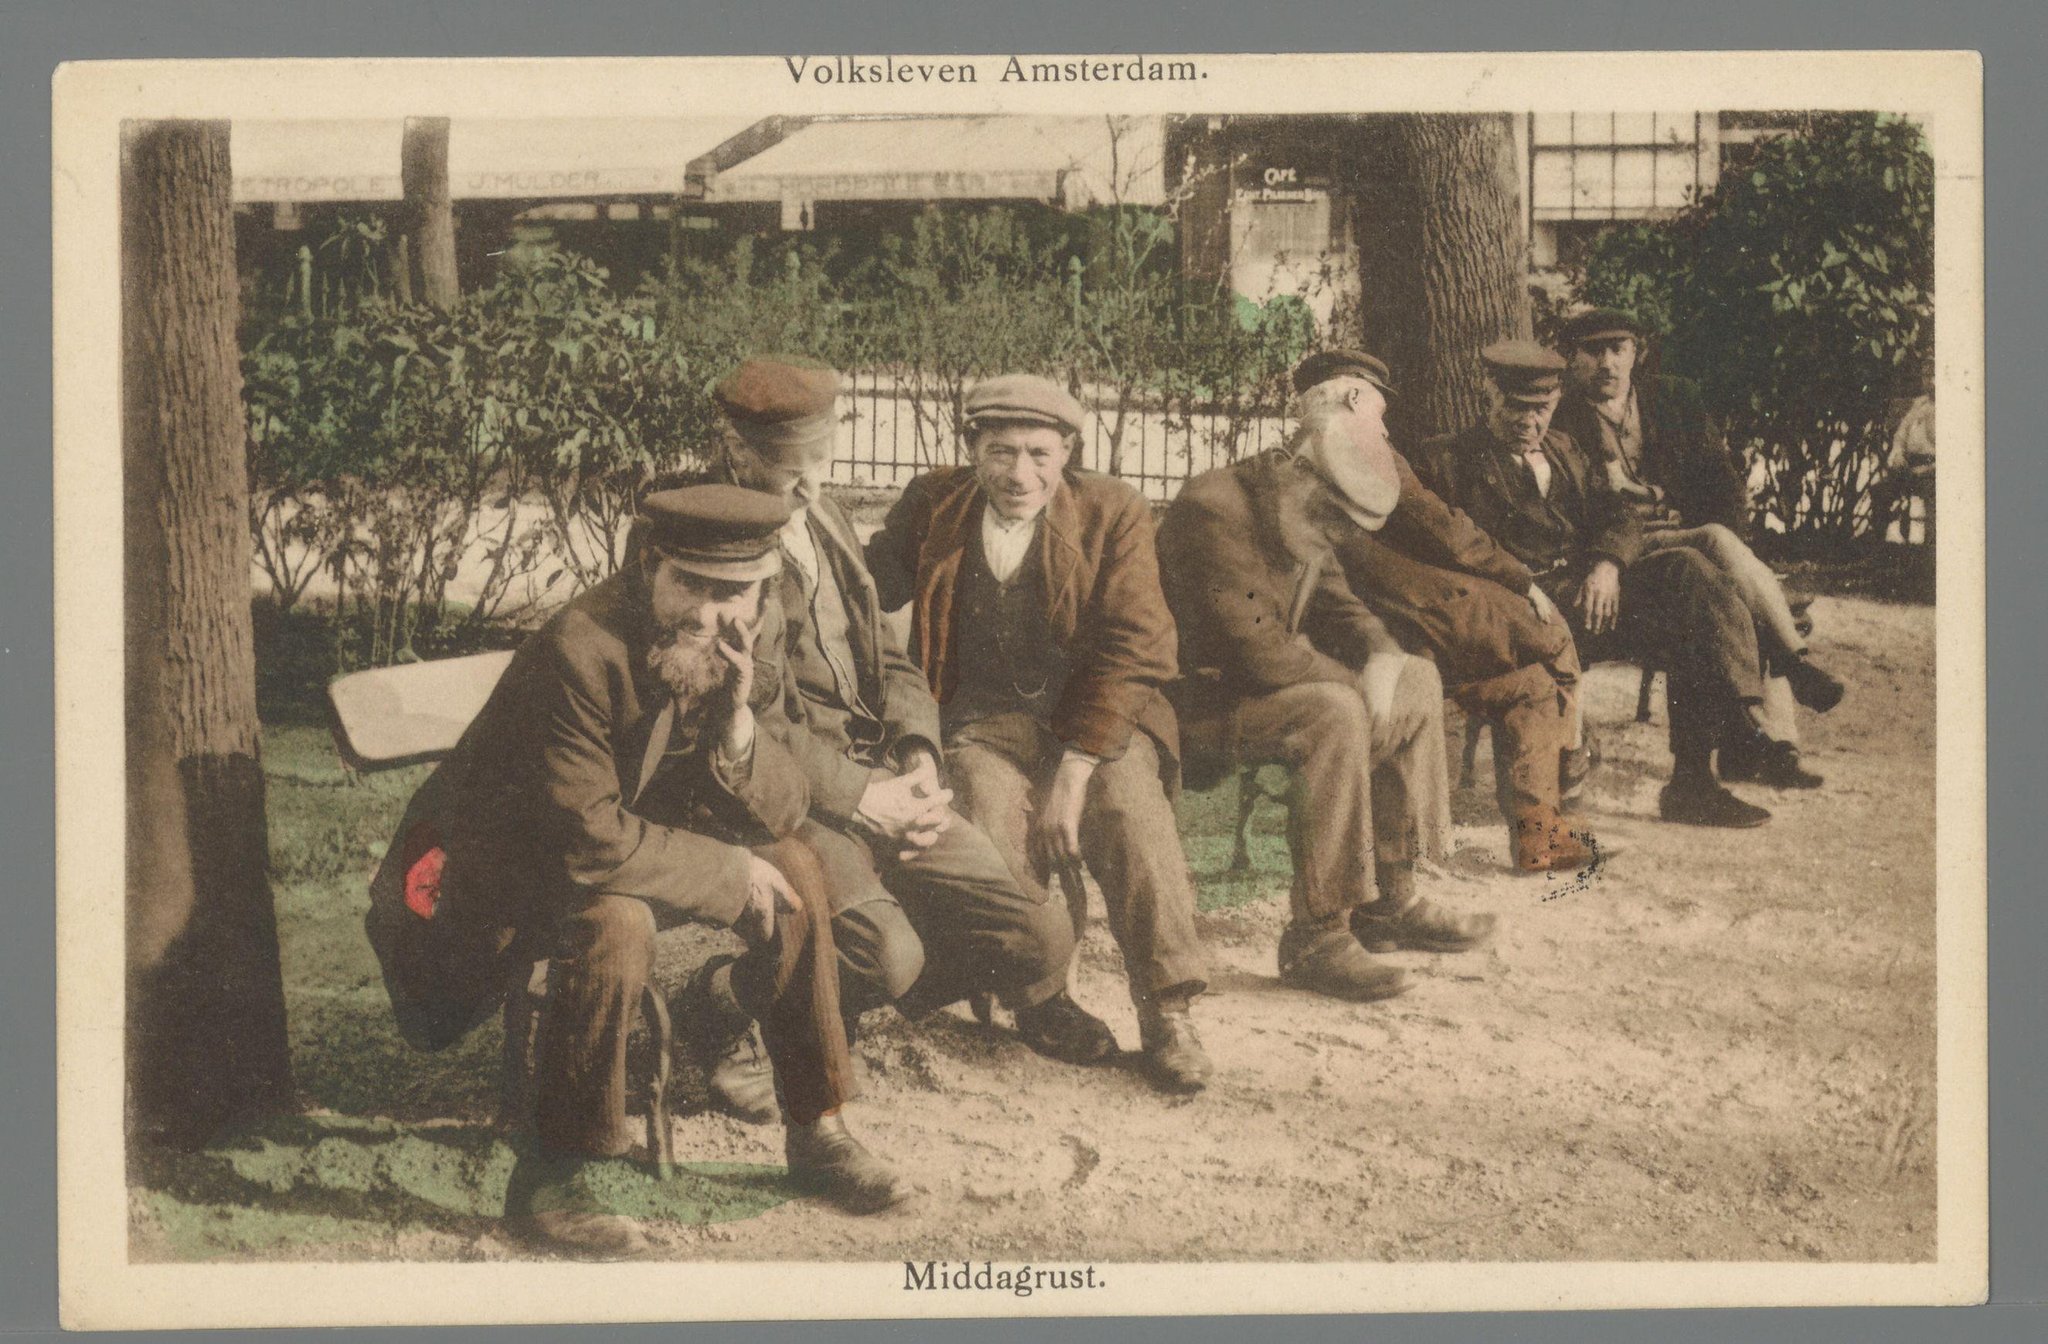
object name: photomechanical print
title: Sabbat rust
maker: Anonymous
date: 1906-1930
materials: cardboard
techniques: photograph, hand coloring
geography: amsterdam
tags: sabbath ~ jewish religion, family life at home, amsterdam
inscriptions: collector's mark: Lugt 2888